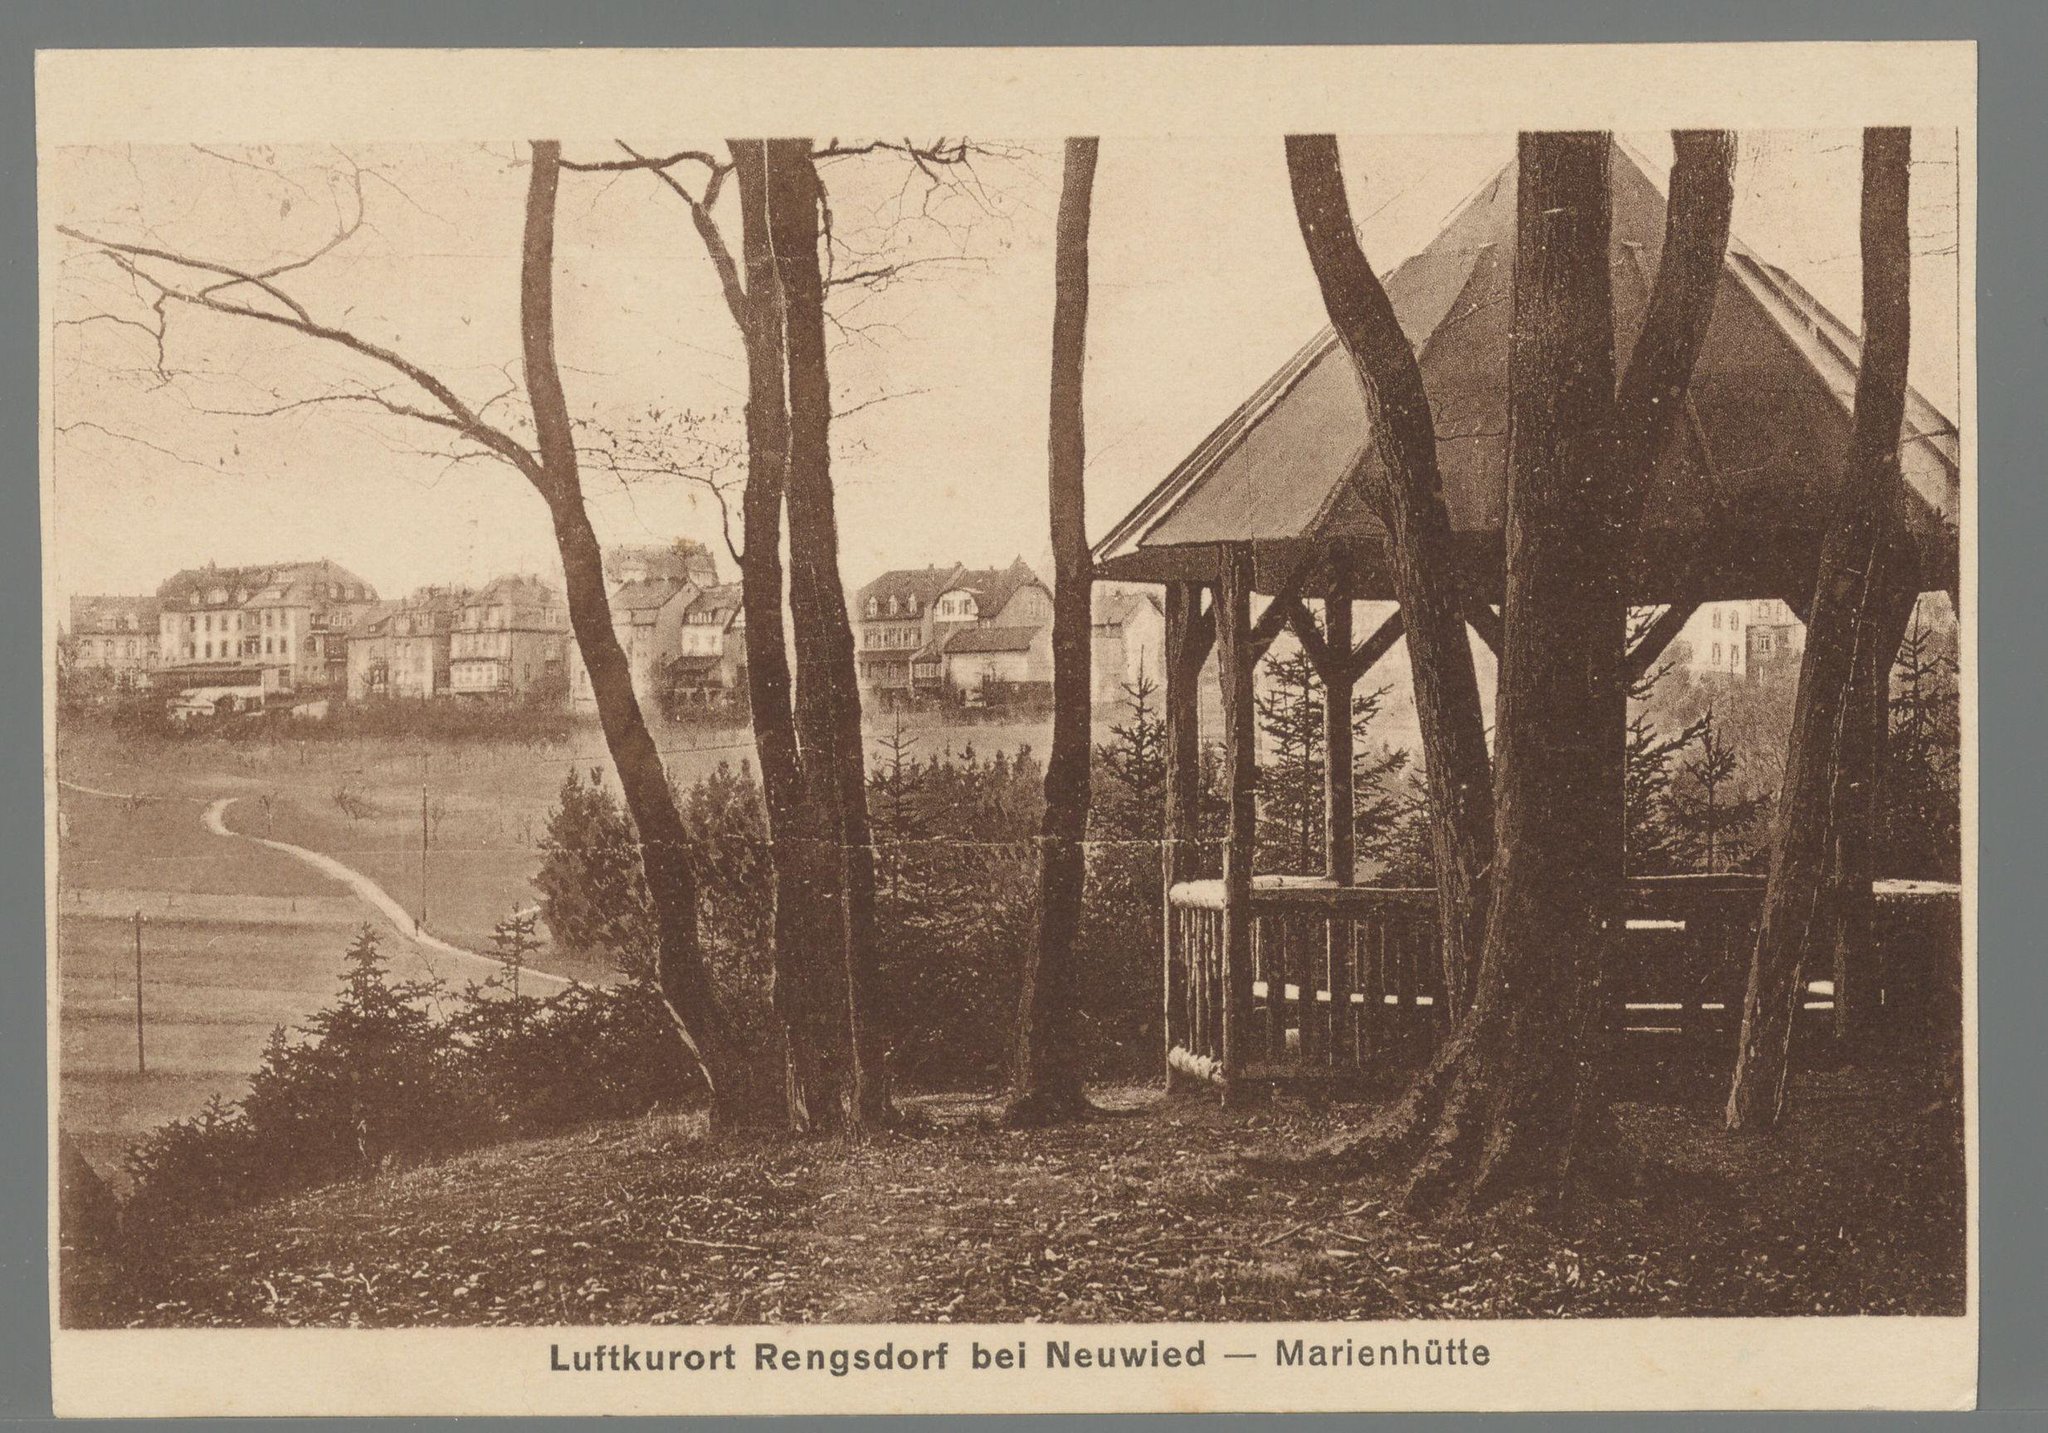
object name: photomechanical print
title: Luftkurort Rengsdorf bei Neuwied - Marienhütte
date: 1905-1930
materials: cardboard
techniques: photograph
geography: rengsdorf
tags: city-view, and landscape with man-made constructions